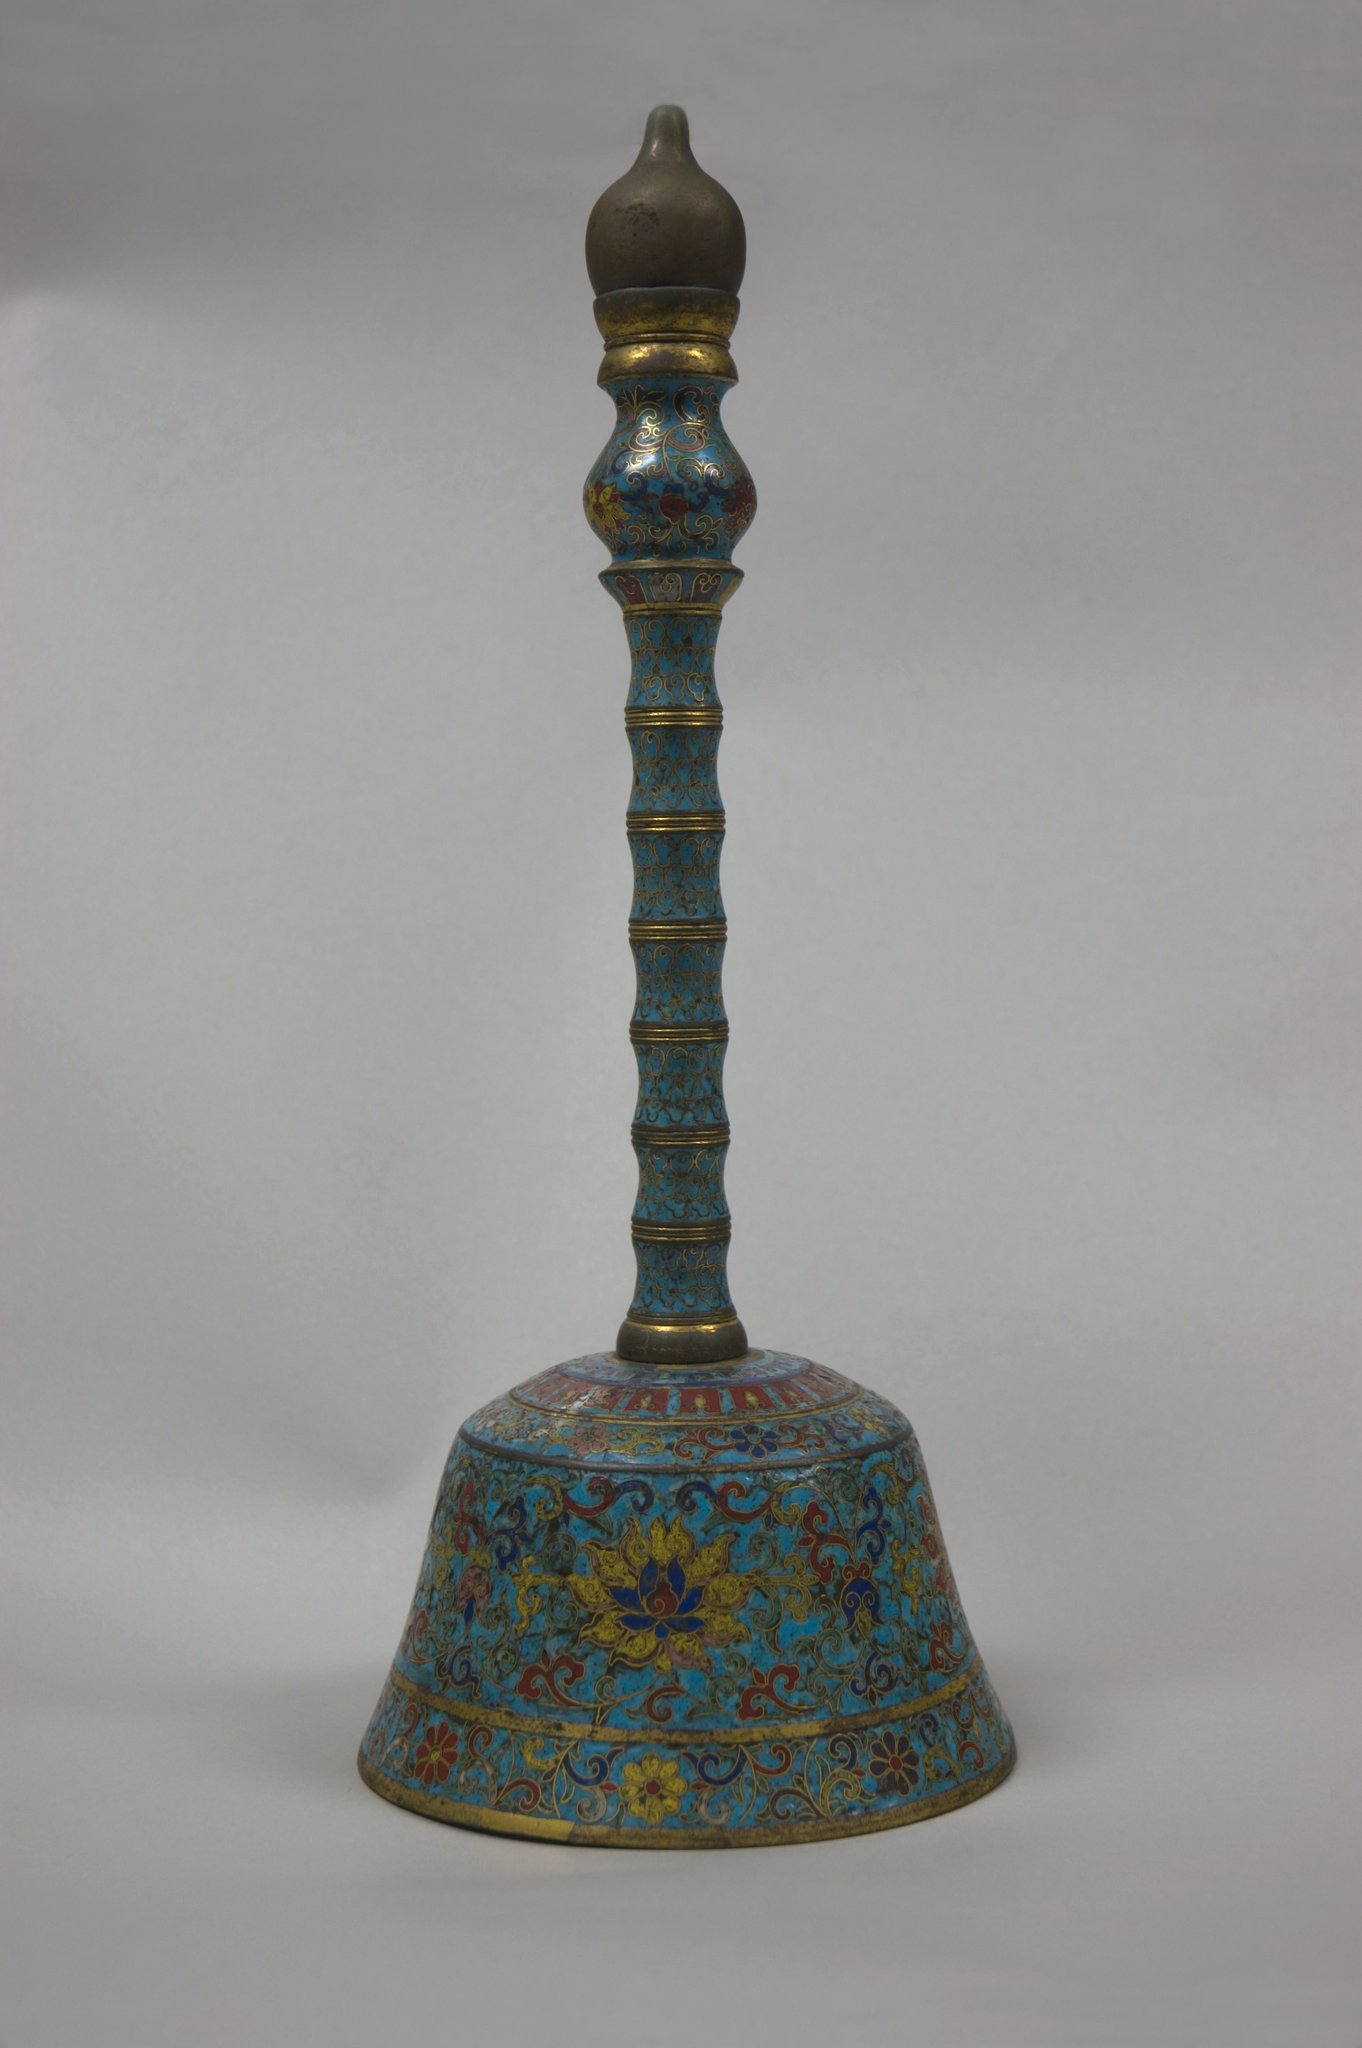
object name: bell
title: Conical Bell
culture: chinese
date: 1662-1722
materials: copper, enamel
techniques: enamel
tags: flowers